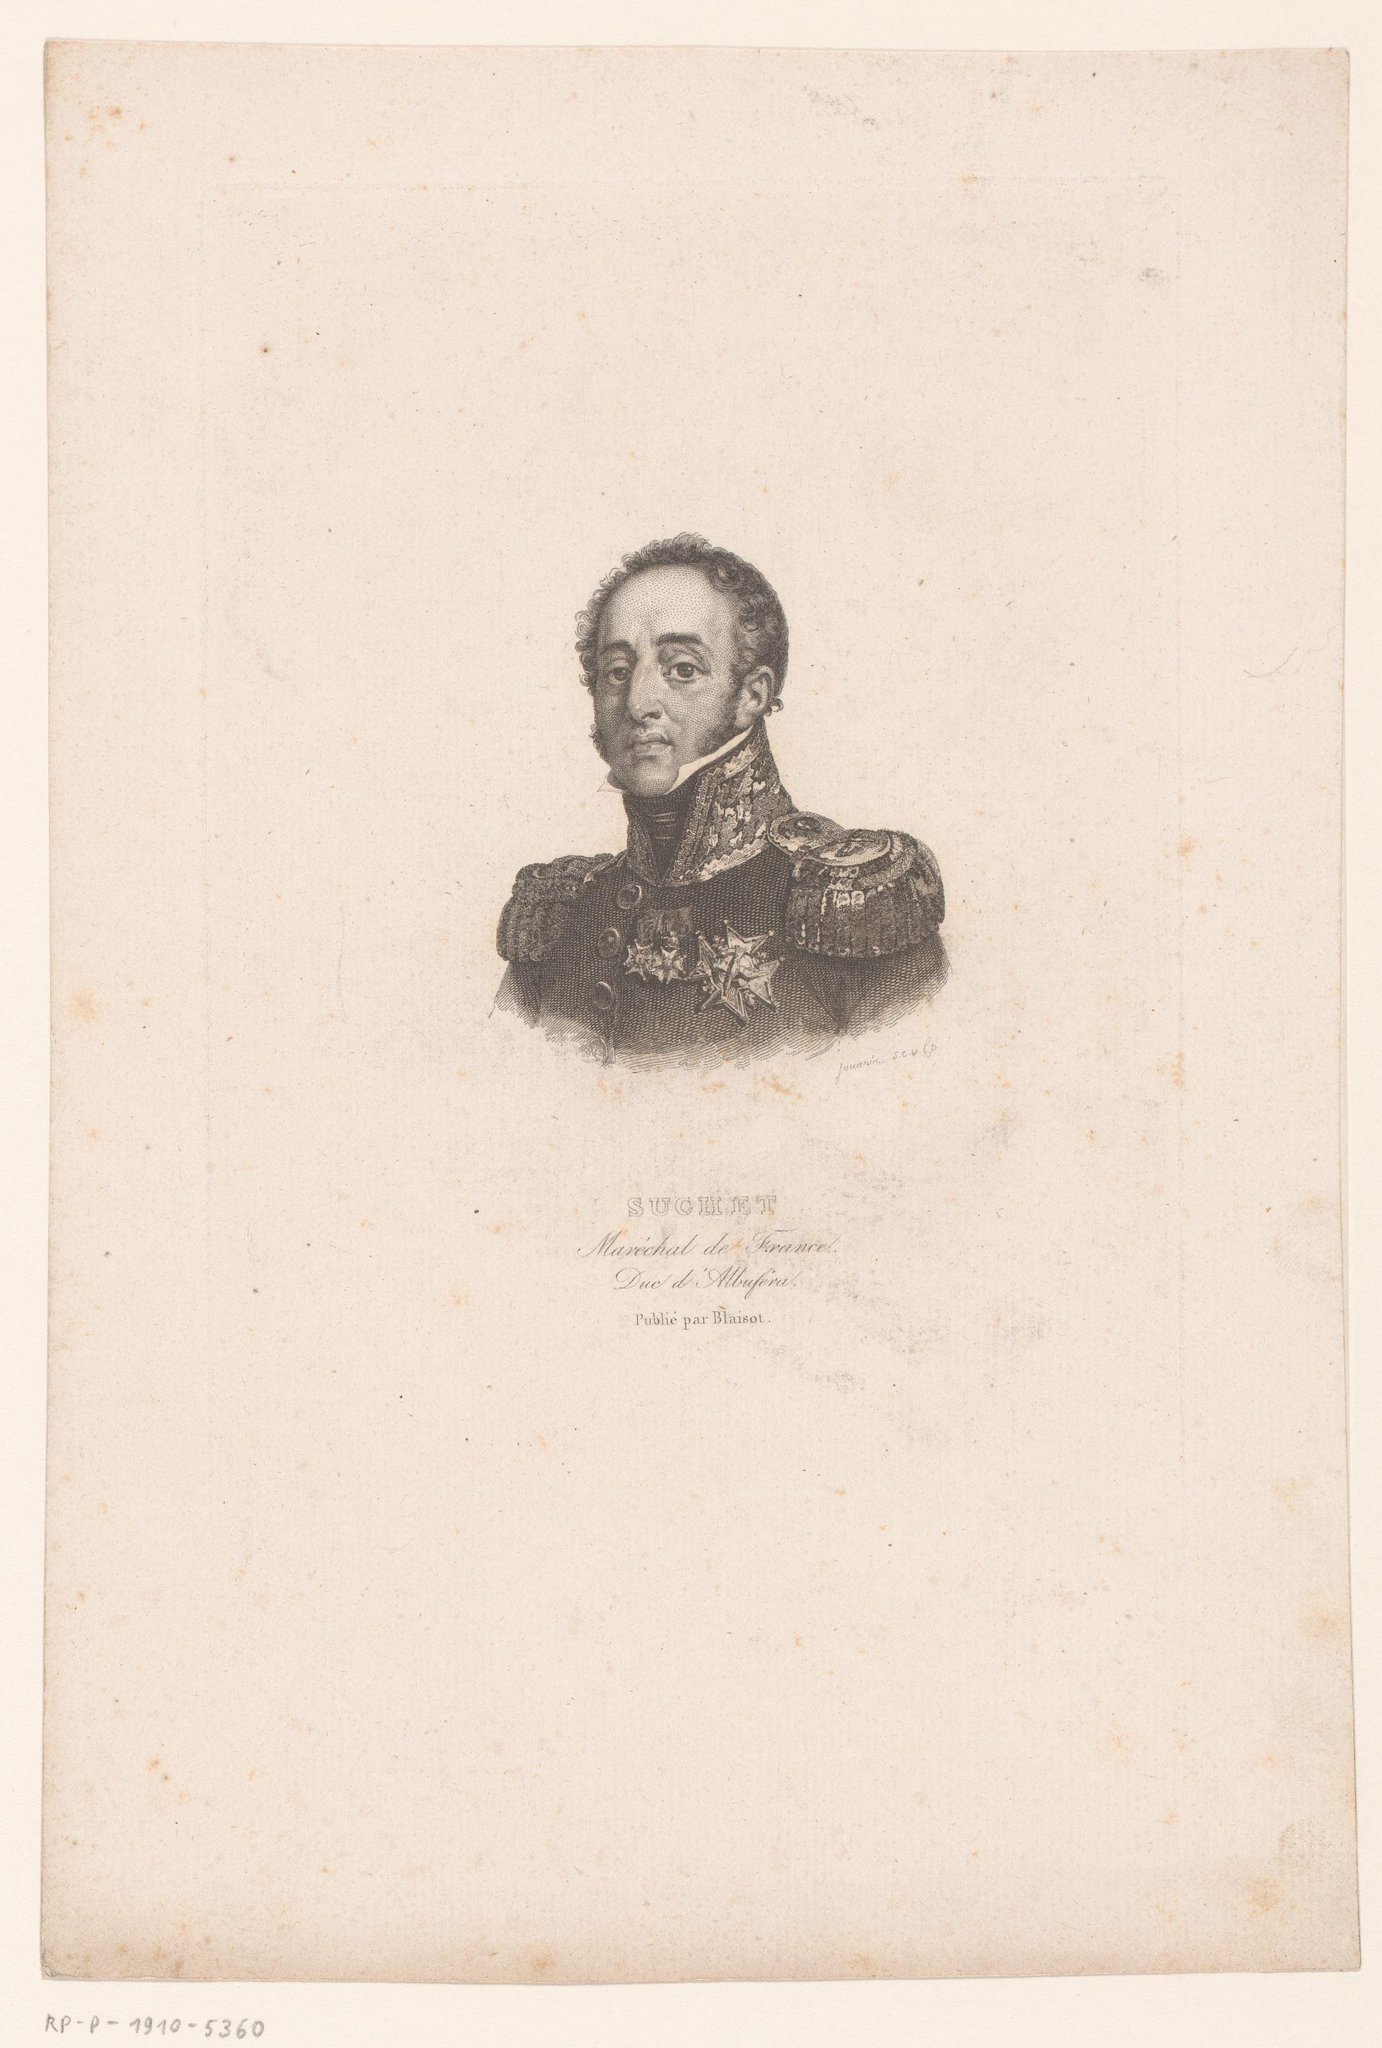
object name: print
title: Portret van Louis Gabriel Suchet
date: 1830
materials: paper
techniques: etching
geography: france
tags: ranks in the army, historical persons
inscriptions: collector's mark: Lugt 2228